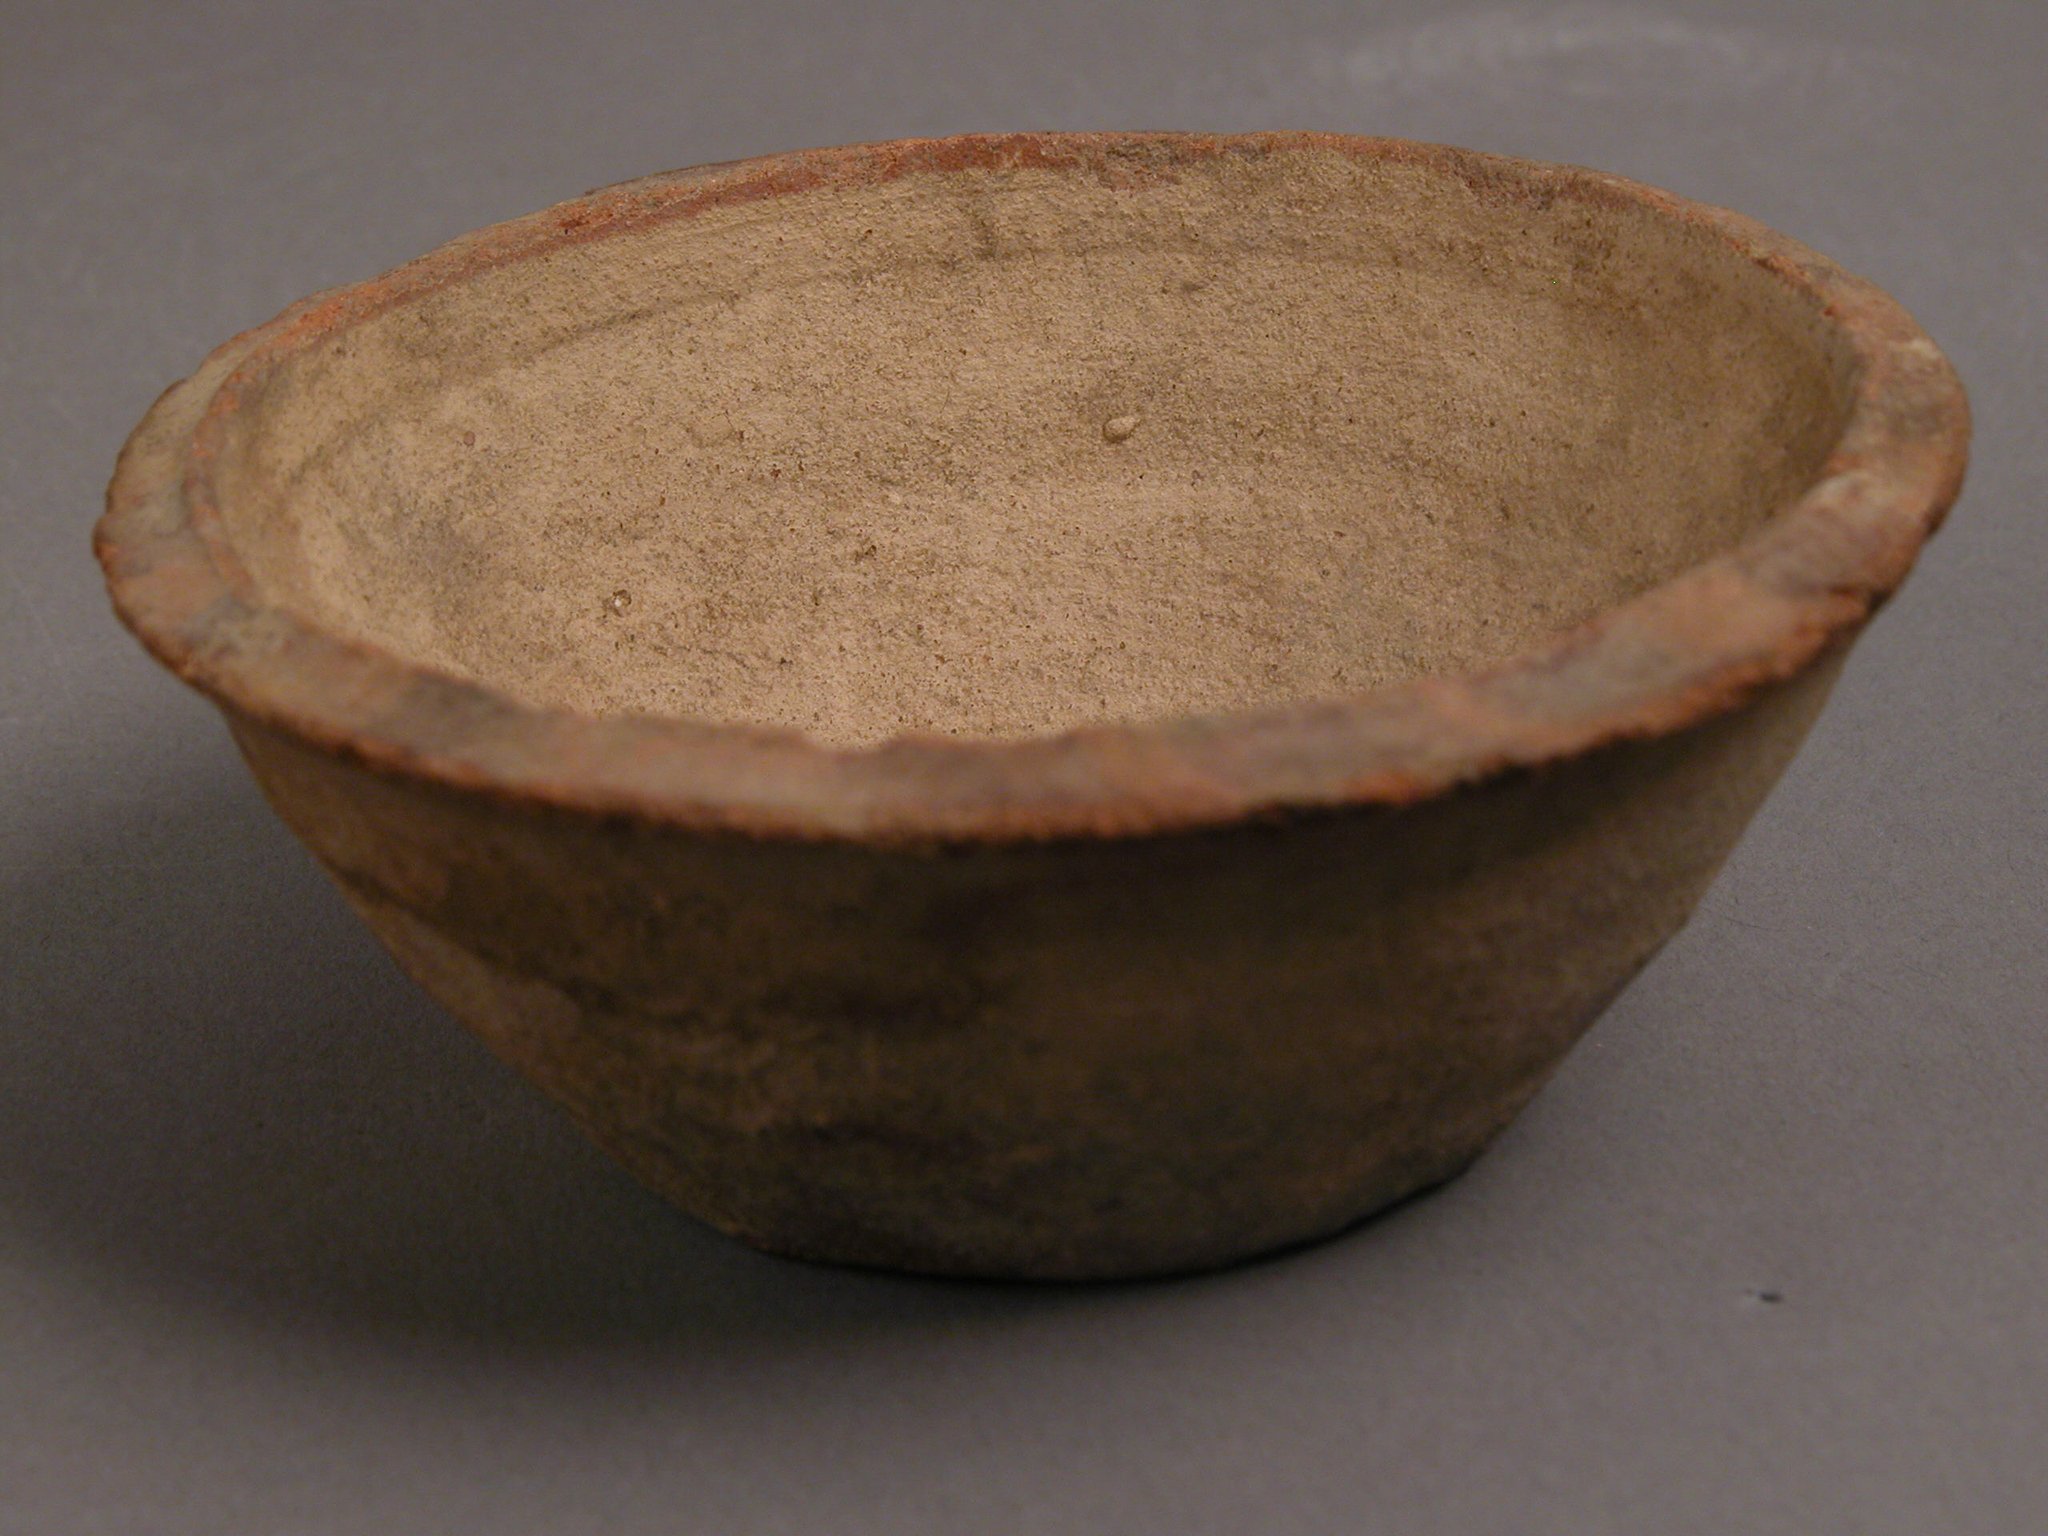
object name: bowl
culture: coptic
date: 301-700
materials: earthenware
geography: egypt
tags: bowls